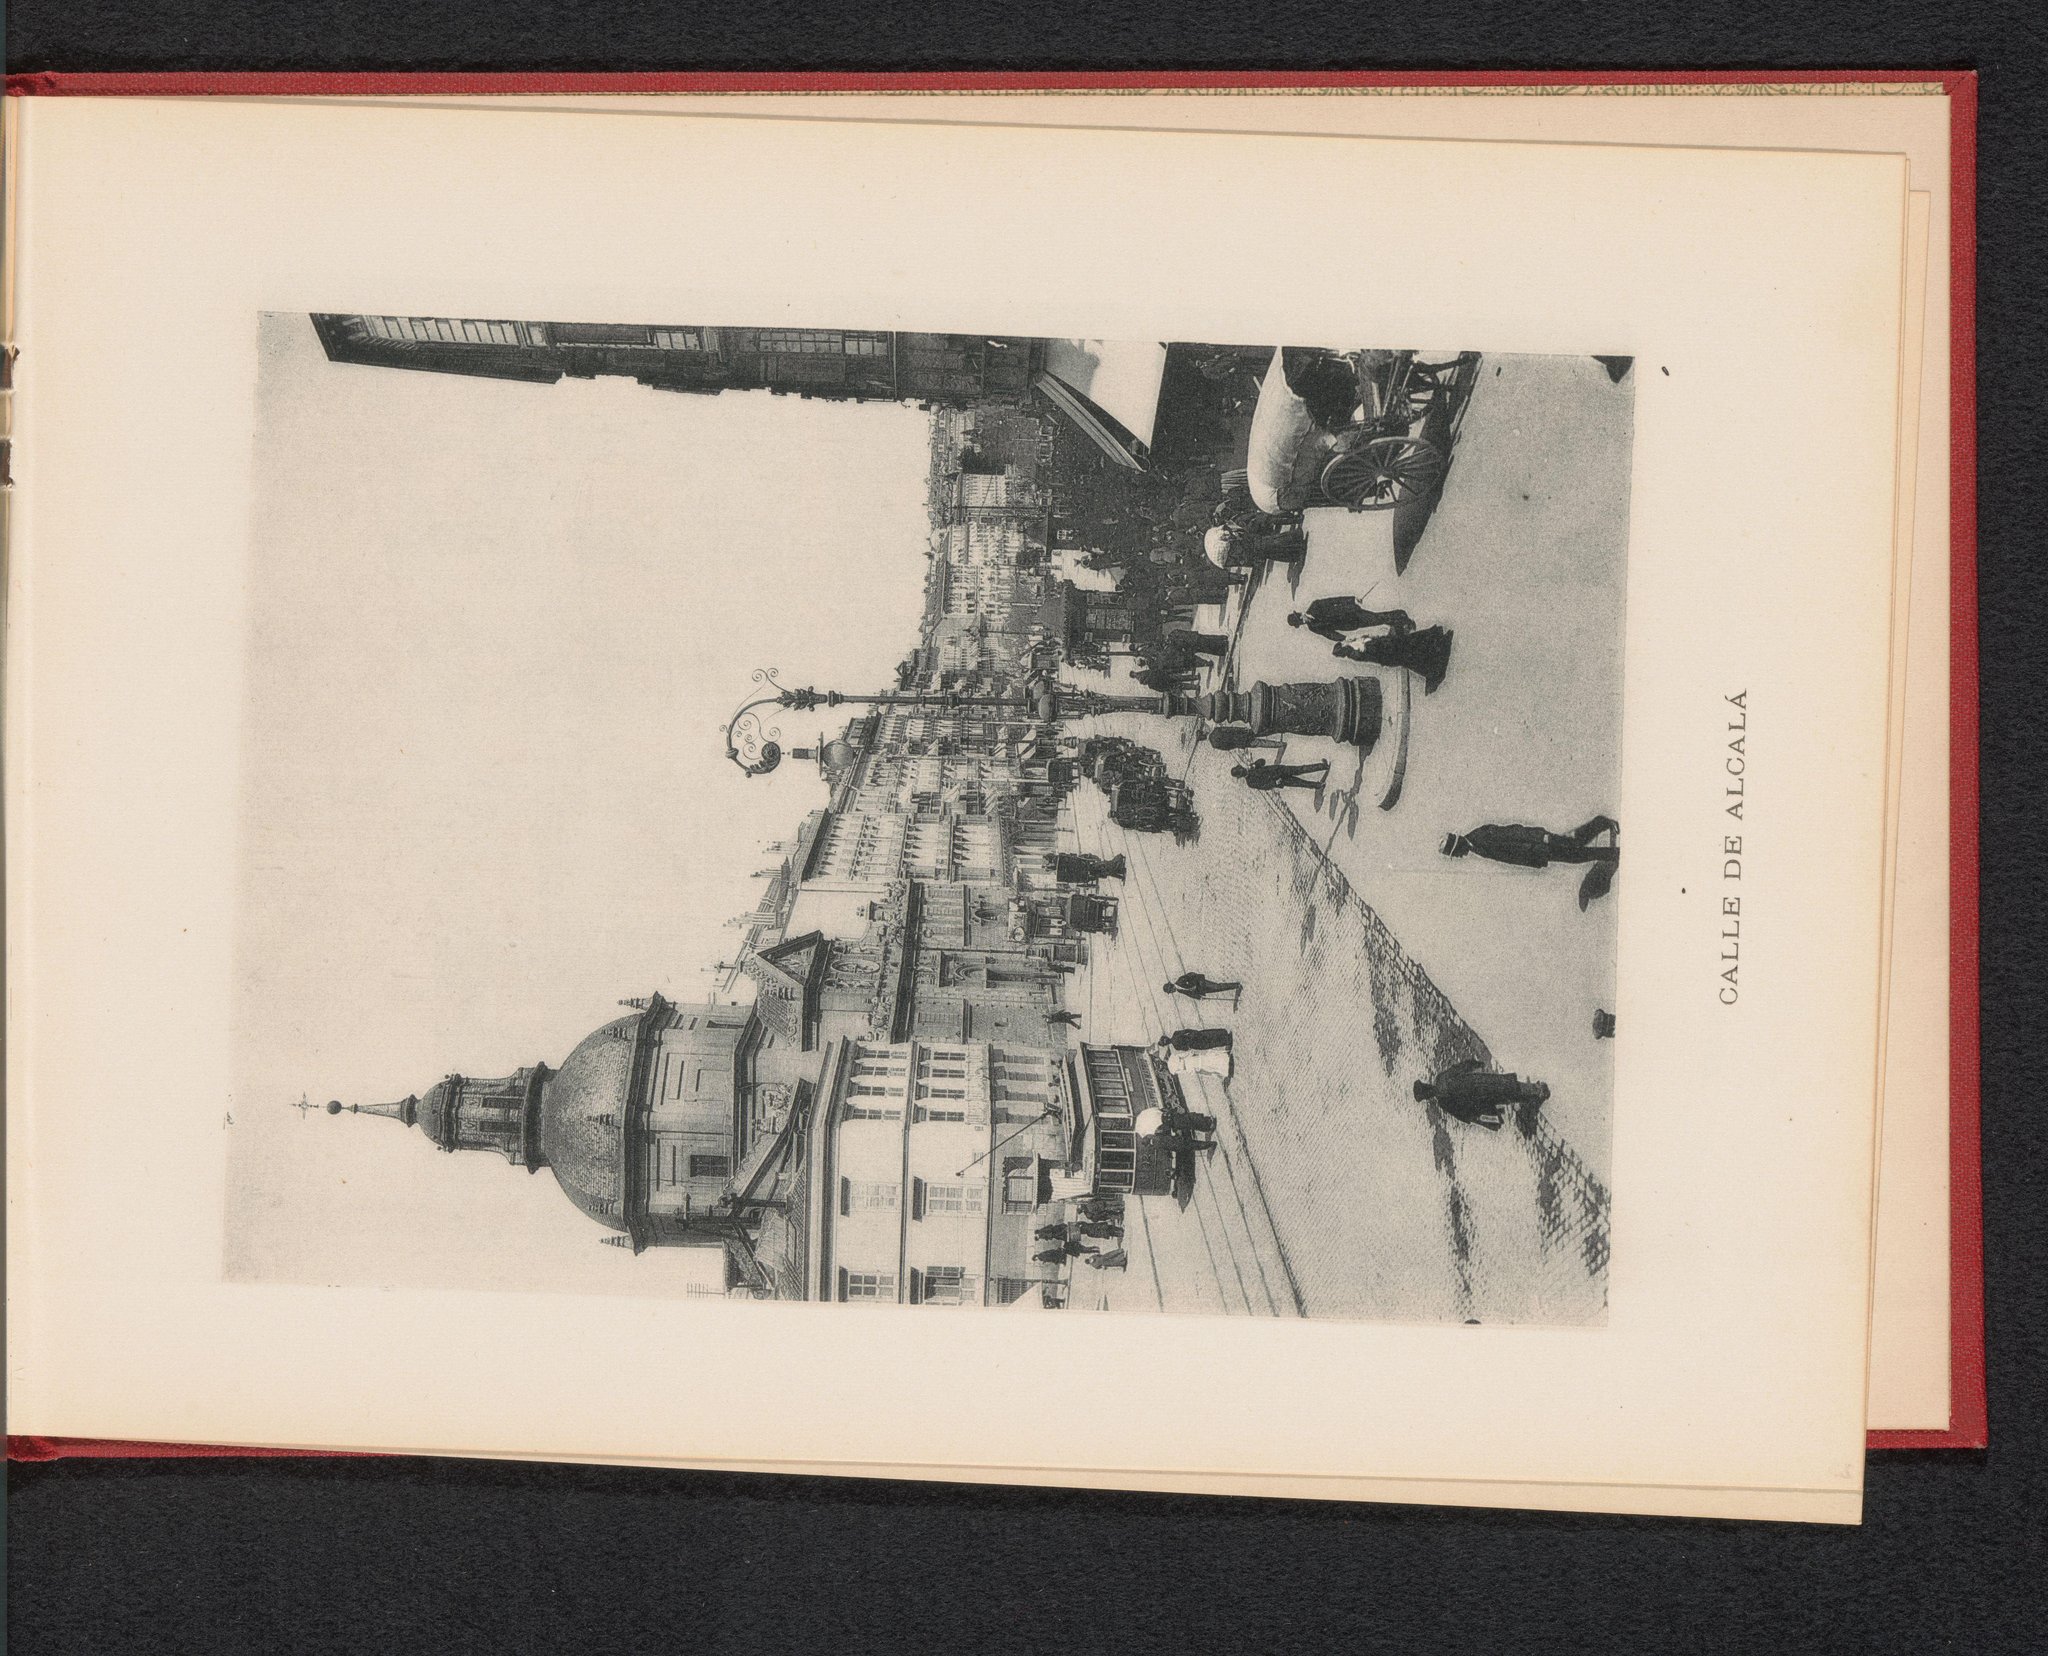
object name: photomechanical print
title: Gezicht op de Calle de Alcalá met links de Iglesia de las Calatravas in Madrid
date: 1888-1898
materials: paper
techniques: photograph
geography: calle de alcalá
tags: tramway, tram, street